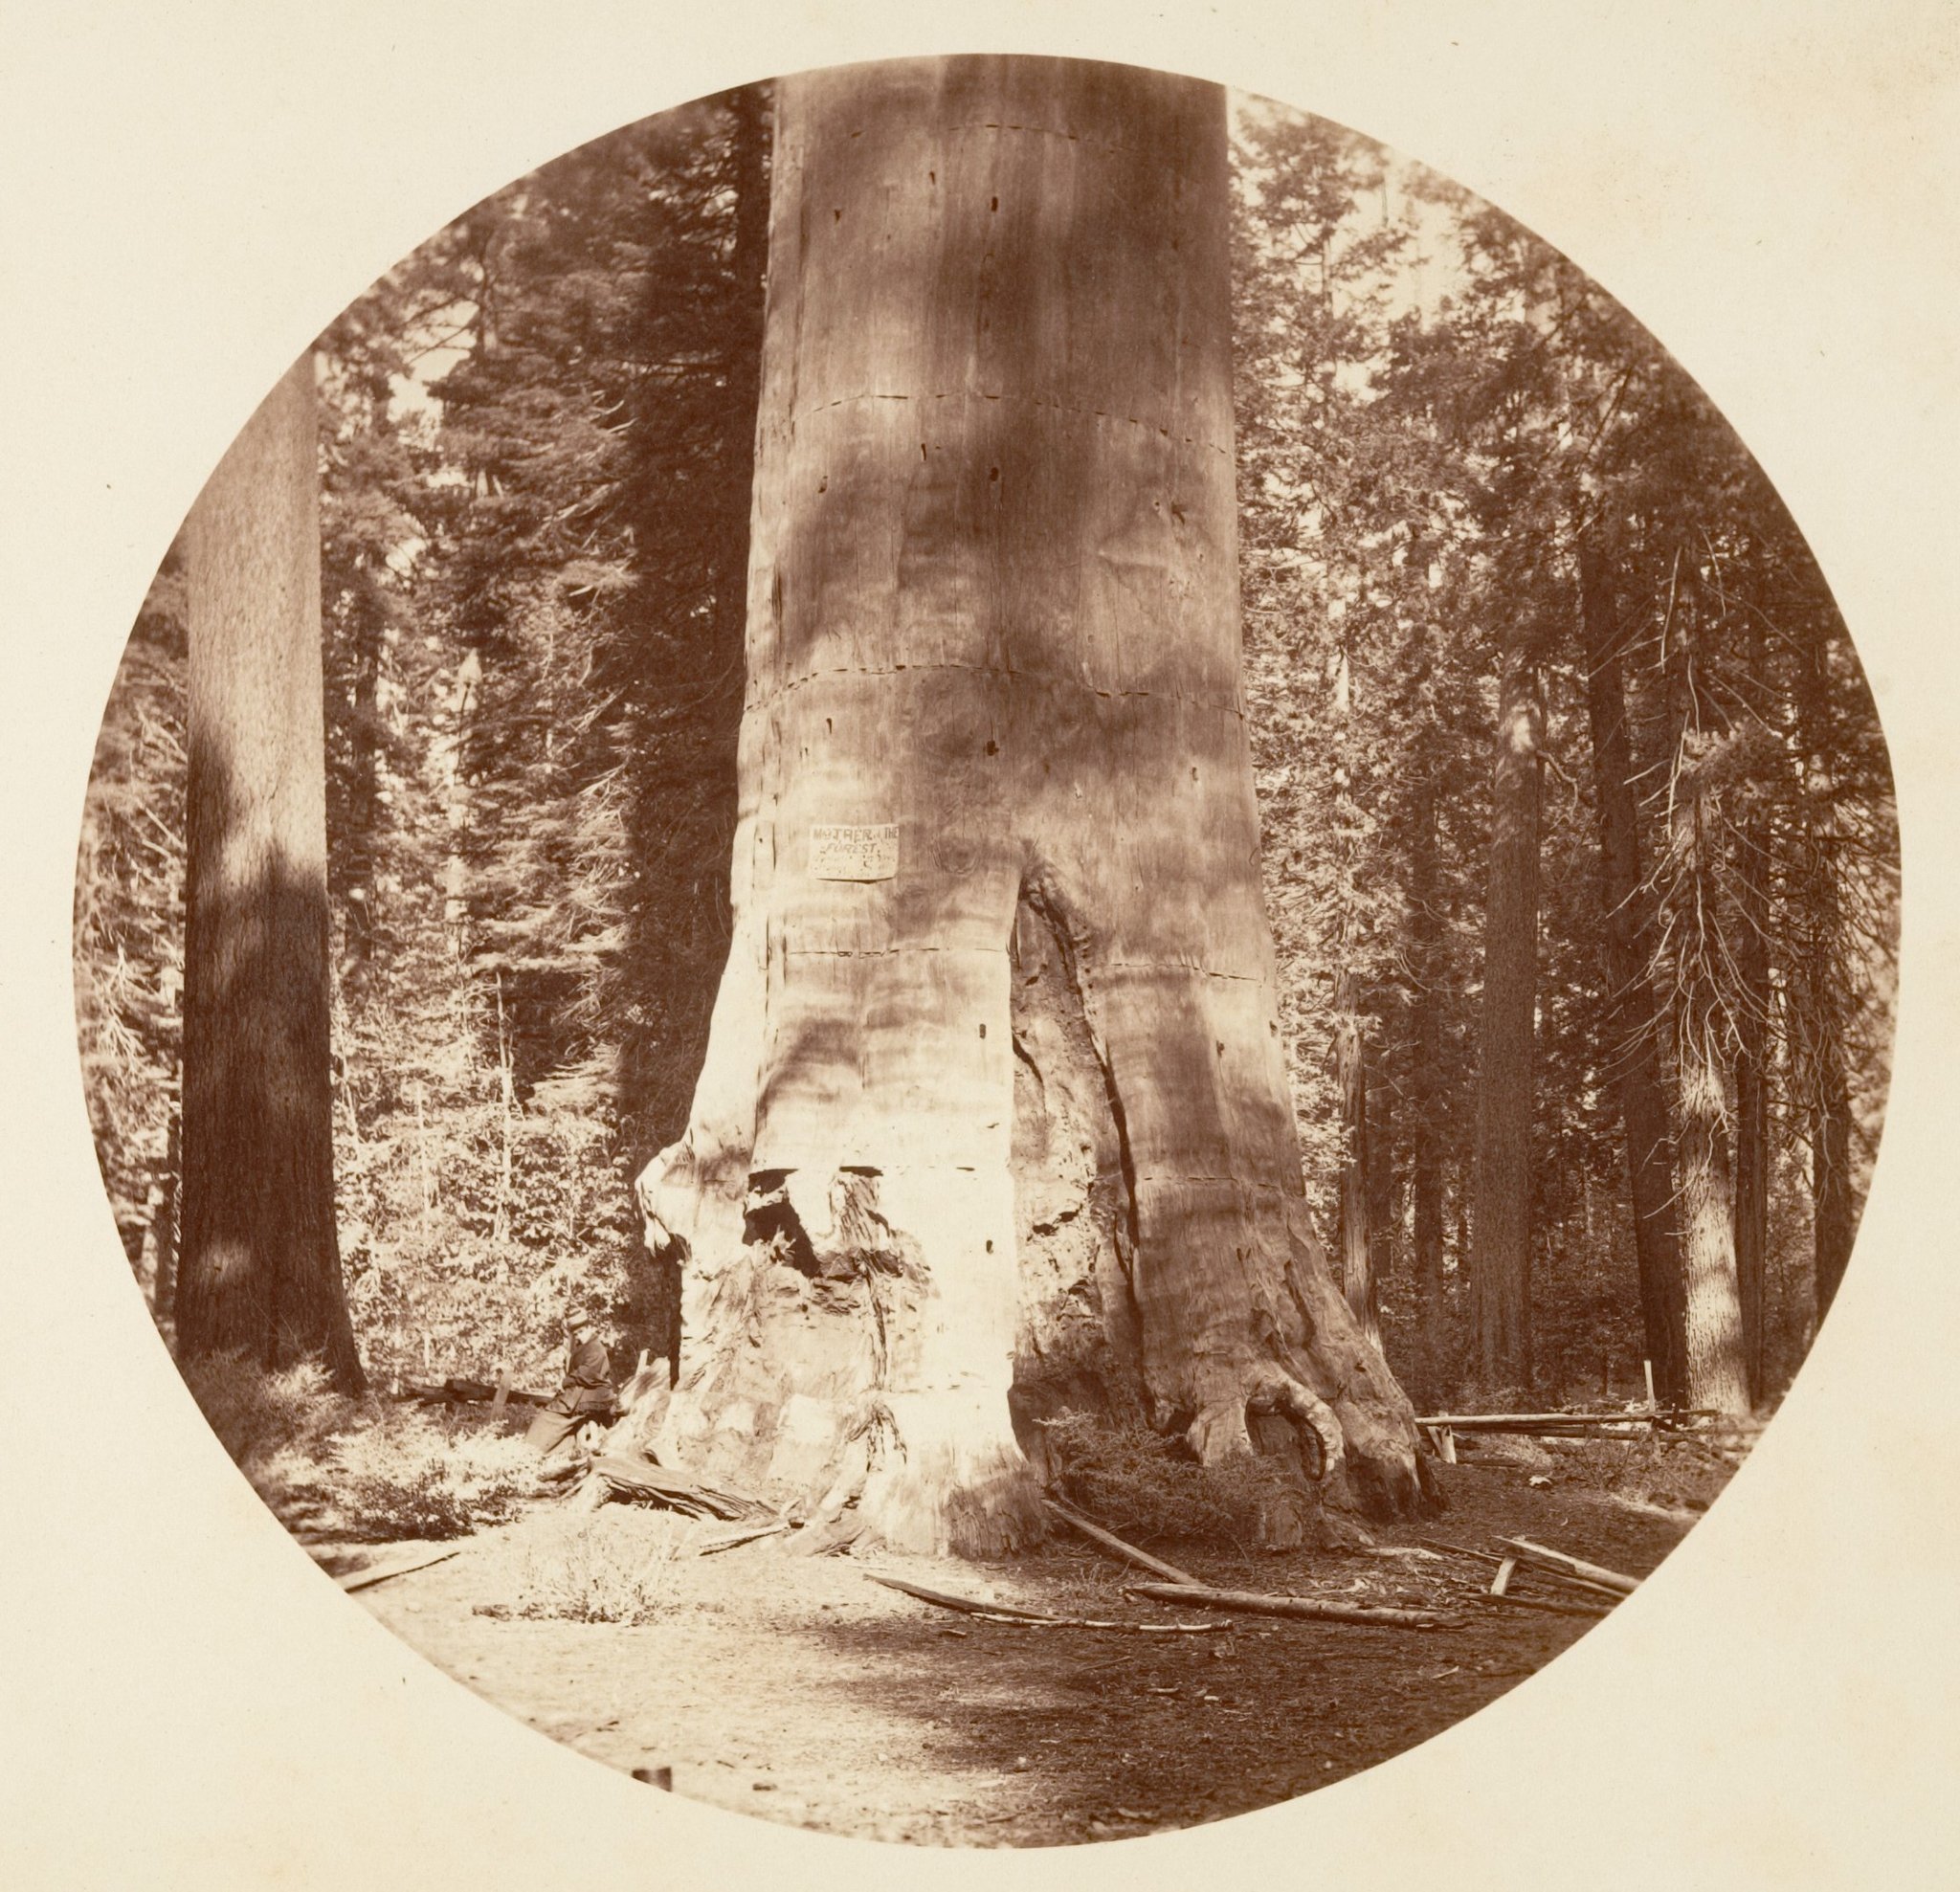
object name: photograph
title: The Mother of the Forest - Calaveras Grove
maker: carleton e. watkins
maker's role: artist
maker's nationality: american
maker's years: 1829-1916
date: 1878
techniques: albumen silver print, glass negative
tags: forests,trees